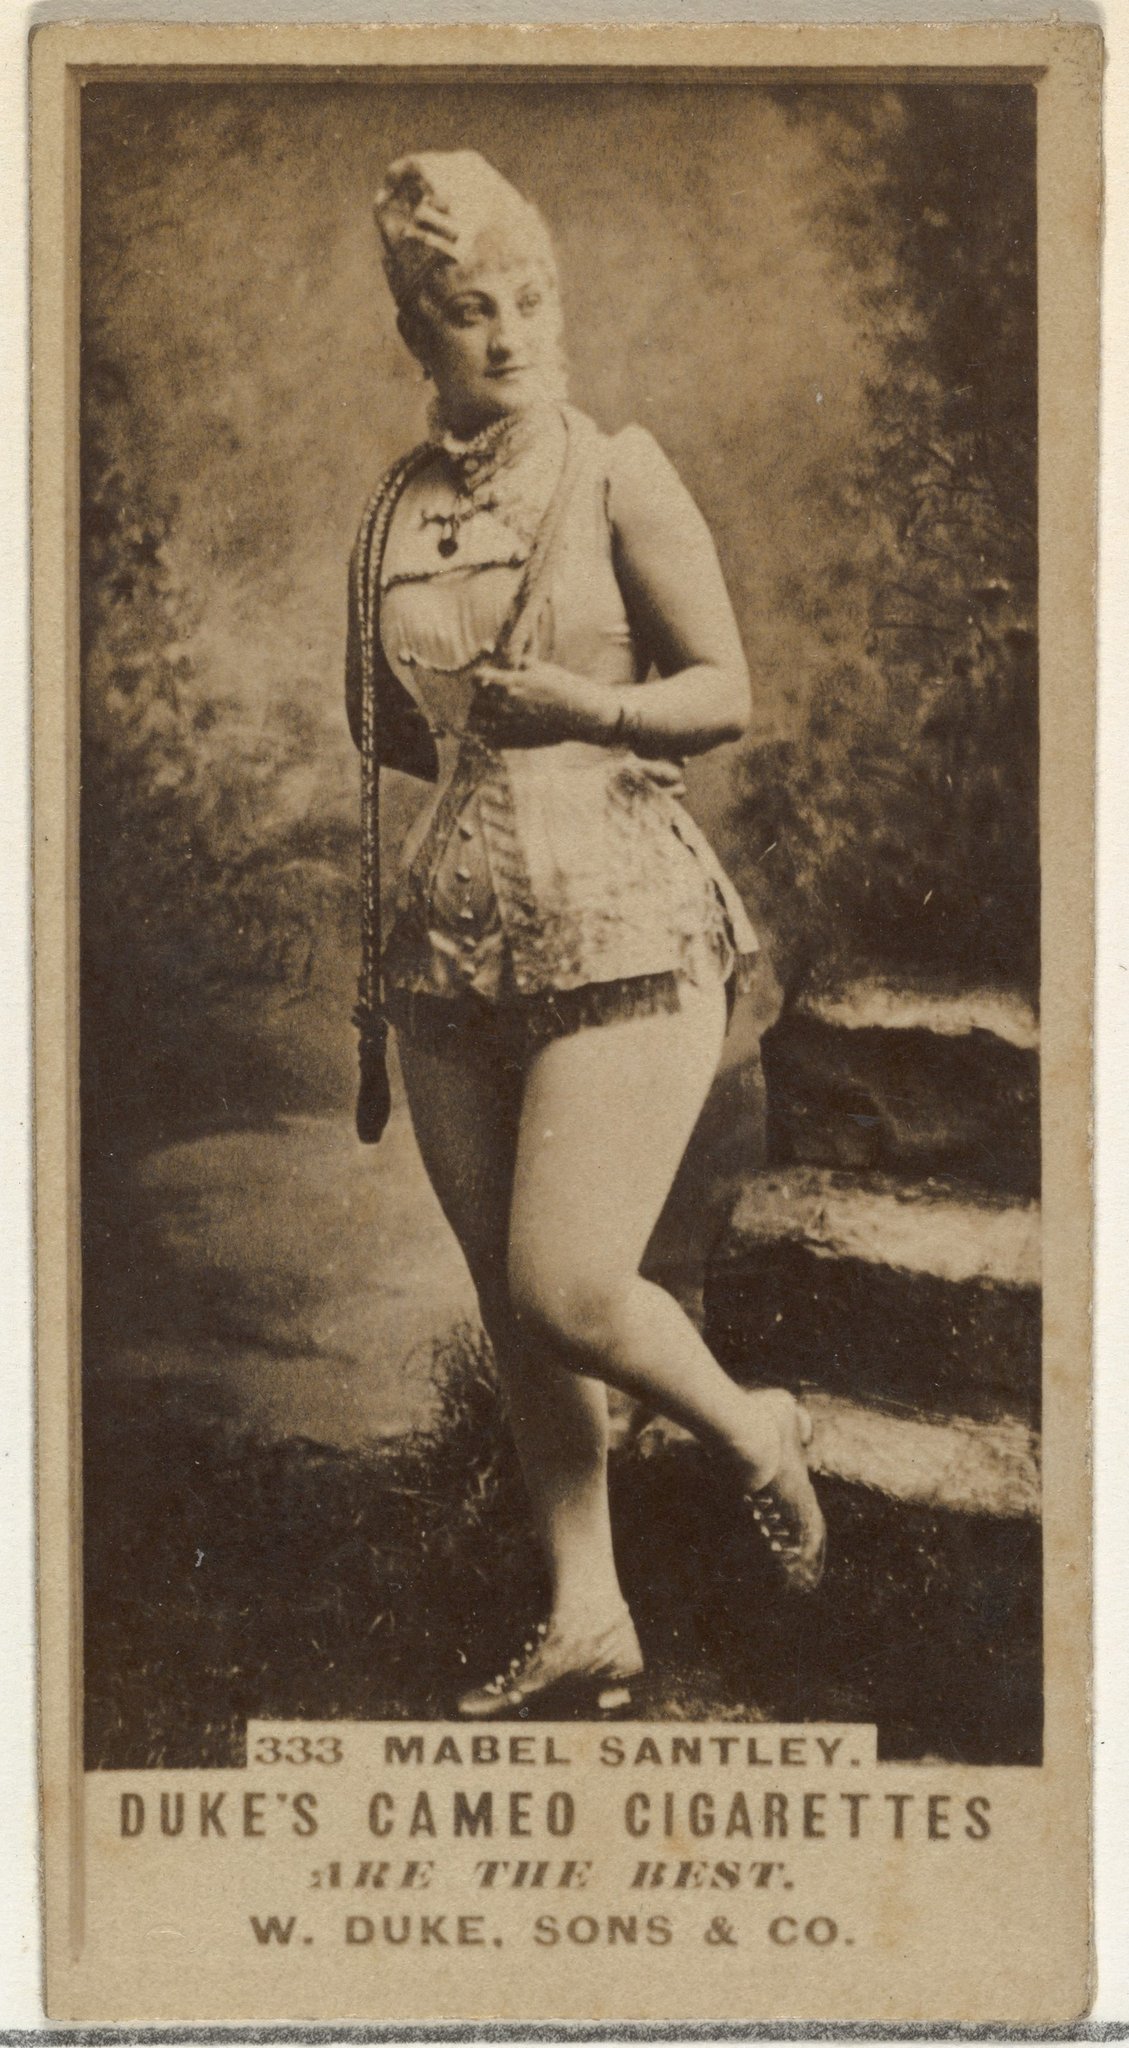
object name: photograph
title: Card Number 333, Mabel Santley, from the Actors and Actresses series (N145-5) issued by Duke Sons & Co. to promote Cameo Cigarettes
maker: w. duke, sons & co.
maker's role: publisher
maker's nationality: american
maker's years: 1870-1920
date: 1880-1889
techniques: albumen silver print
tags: portraits,women,actresses